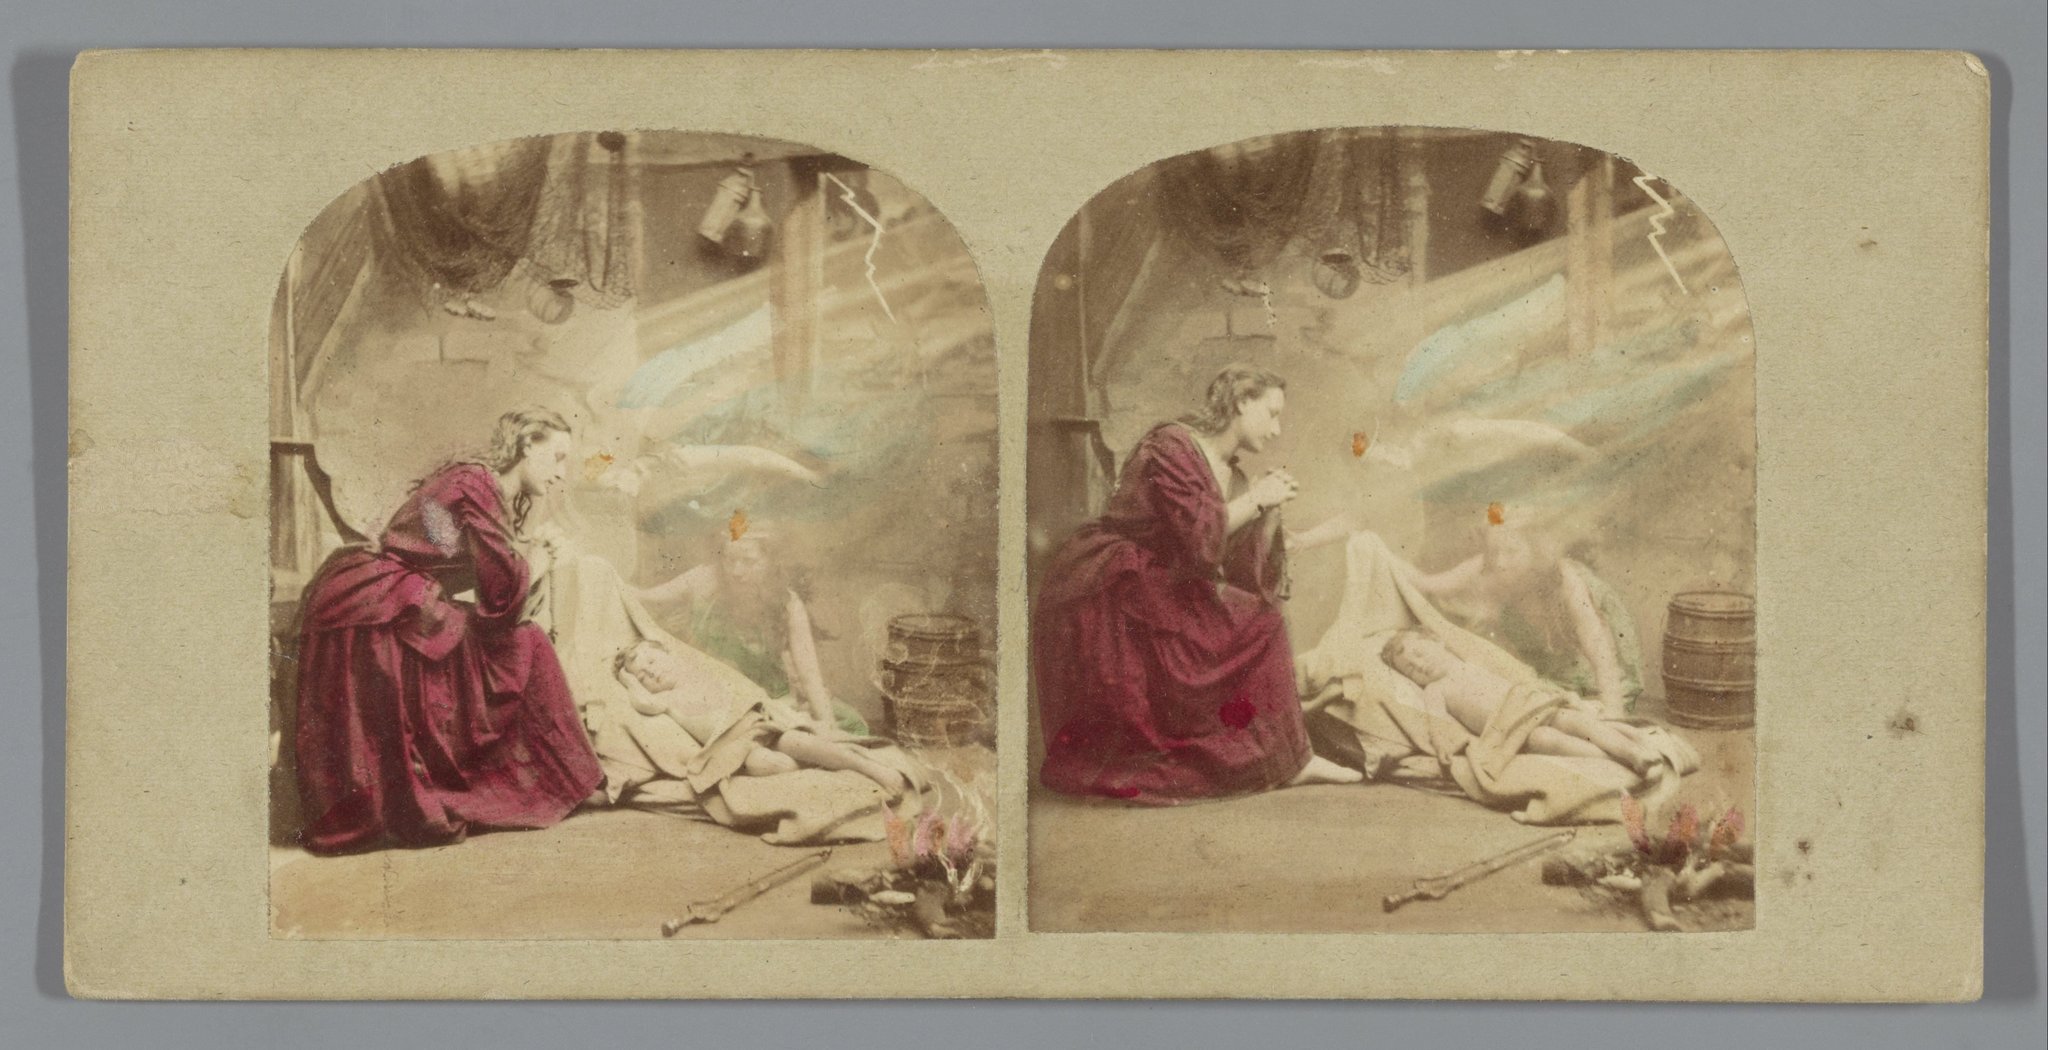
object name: stereograph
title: Slapend kind omringd door beschermengelen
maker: Anonymous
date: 1852-1863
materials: cardboard, paper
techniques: albumen print, hand coloring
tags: guardian angel, watching a sleeping child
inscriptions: inscription: ‘JFP’, inscription: ‘No. 15’, inscription: ‘Let A. 4’, inscription: ‘P’